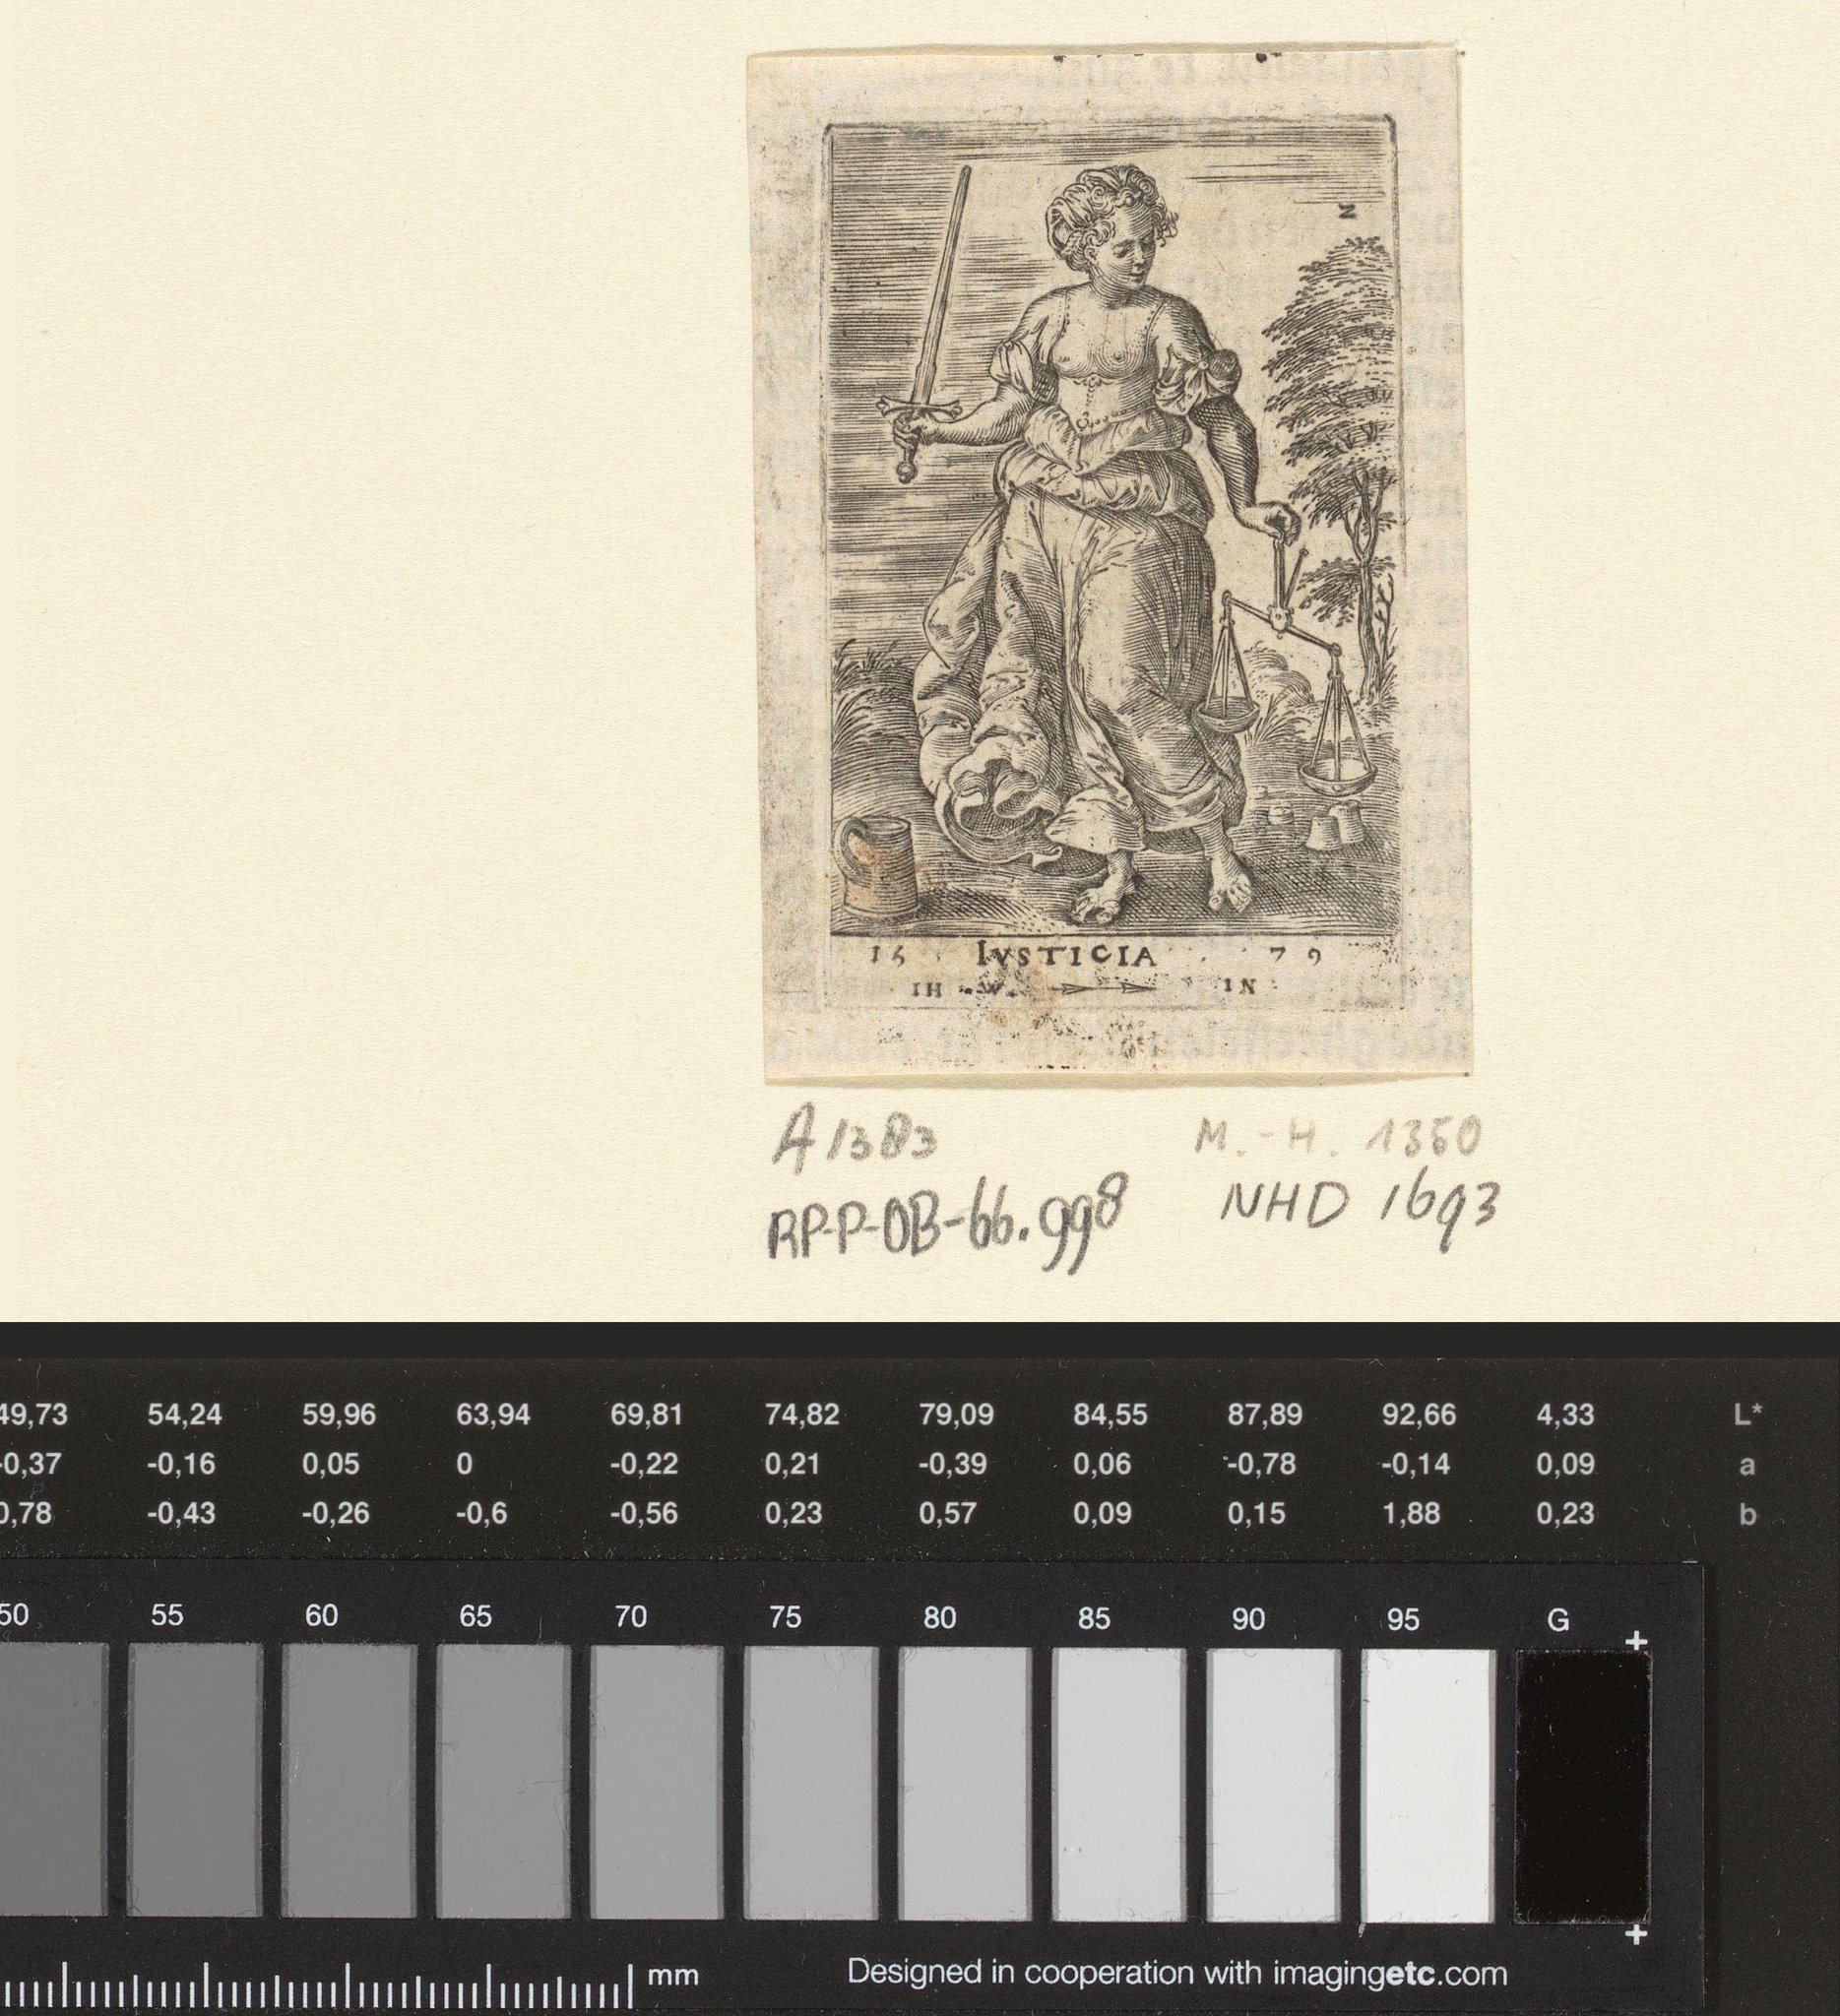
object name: print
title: Rechtvaardigheid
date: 1579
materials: paper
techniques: engraving, letterpress printing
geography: antwerp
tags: justice, 'justitia'; 'giustitia divina' (ripa) ~ one of the four cardinal virtues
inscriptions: collector's mark: Lugt 2228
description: Prent gebruikt als illustratie in: Const-toonneel, inhoudende de beschrijvinghe ende XL. Heerlijcke afbeeldindinghen: Onses Heeren Jesu Christi, met sijne apostelen, ende evangelisten, midtsgaders de hooft-deuchden ende ondeuchden. Ende ten laetsten de seven planeten. In coper gesneden door Johannis Wierix. De beschrijvinge is (...). Delft: Nicolaes de Clerck, 1609.